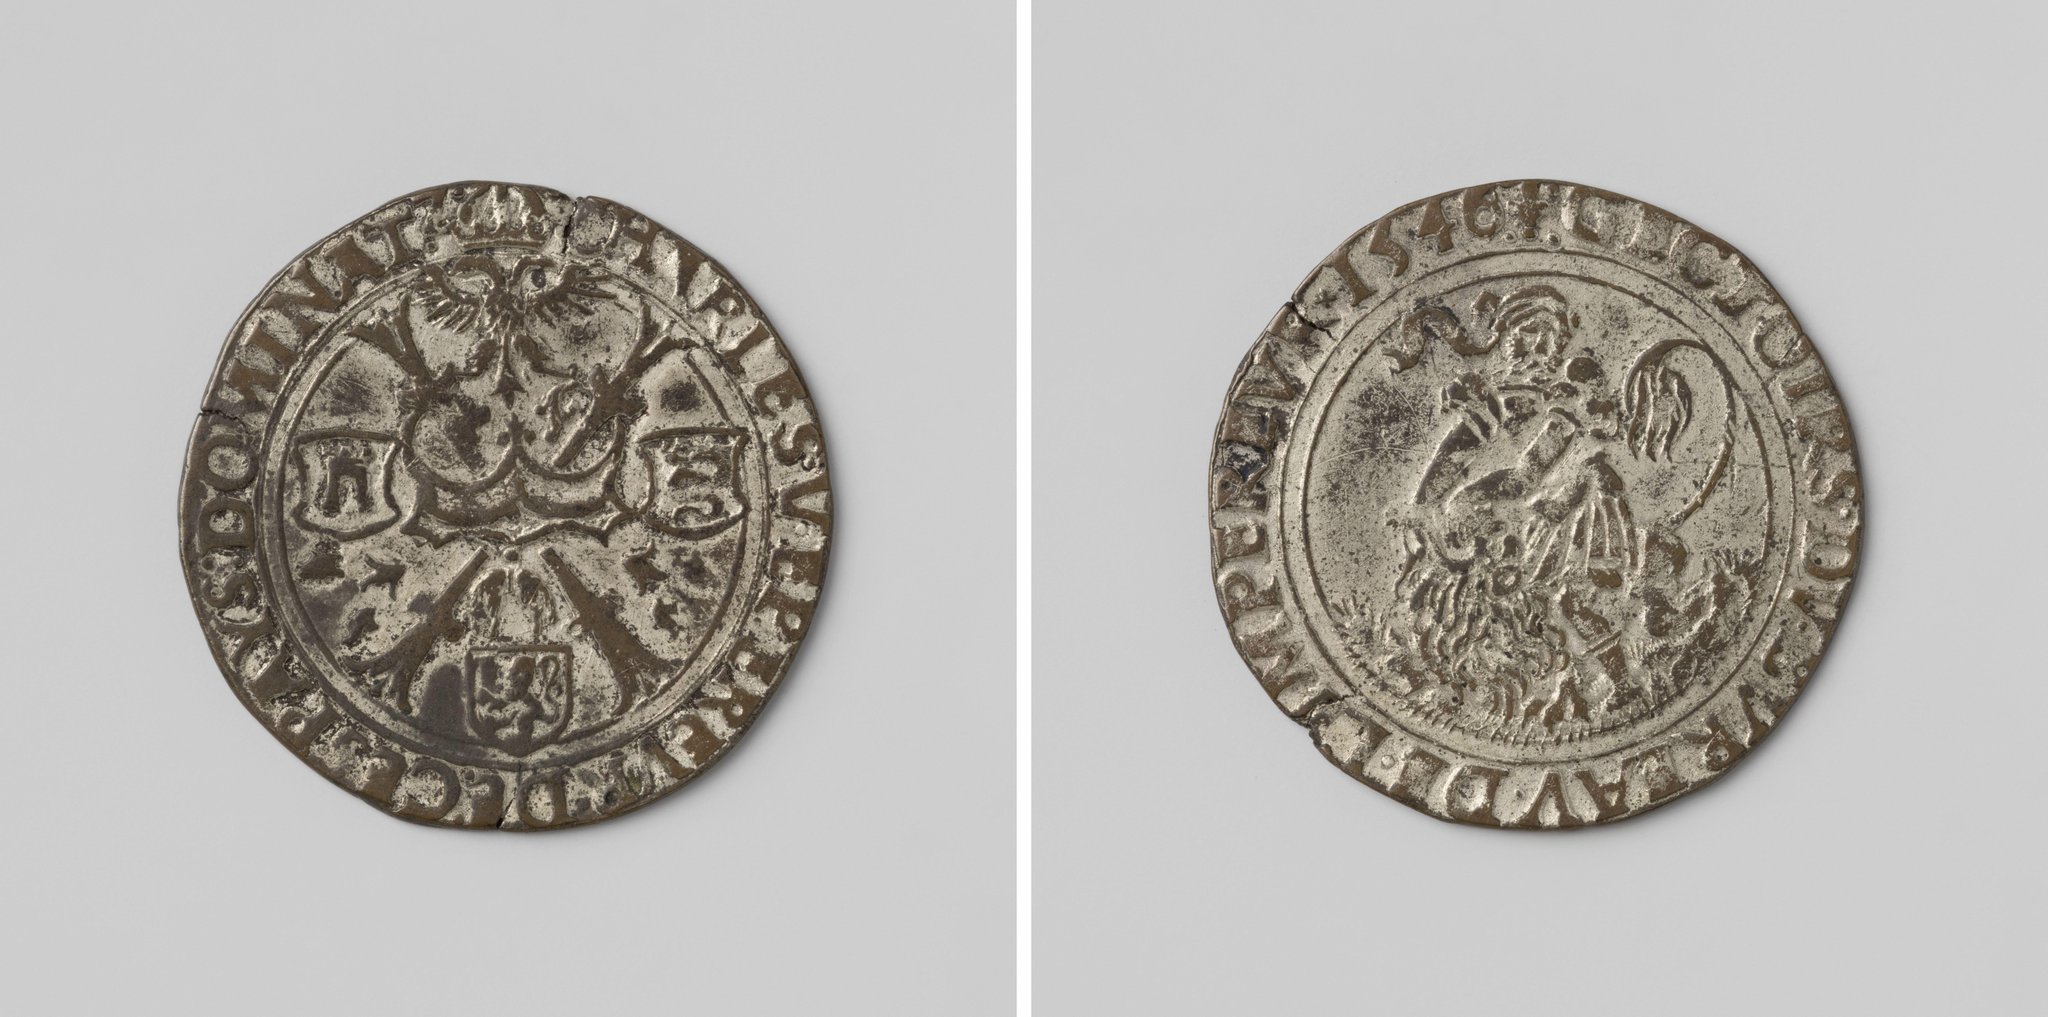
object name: jeton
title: Overwinningen van Karel V, Duits keizer, rekenpenning van het bureau van de keizer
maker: Anonymous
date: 1546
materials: copper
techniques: silvering, striking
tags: charles v (holy roman emperor and king of spain)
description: Koperen penning. Voorzijde: vuurslag, waaraan orde van Gulden Vlies hangt, op Bourgondisch kruis onder tweekoppige adelaar, geflankeerd door en boven wapensschild binnen omschrift. Keerzijde: Herkules, zittend op leeuw, wiens kaken hij uiteen trekt binnen omschrift